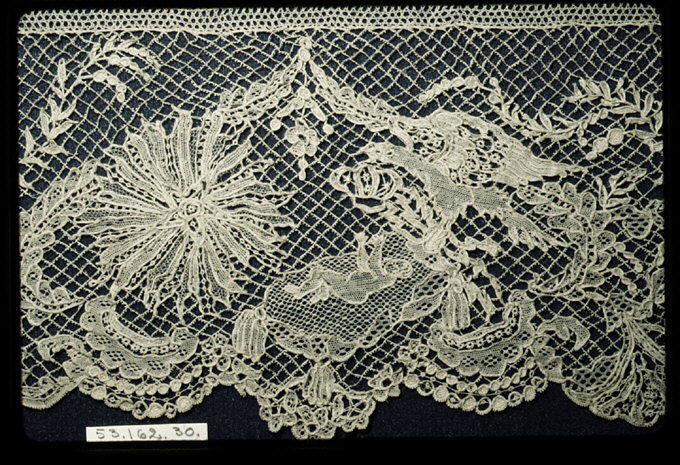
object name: border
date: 1801-1900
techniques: lace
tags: flowers